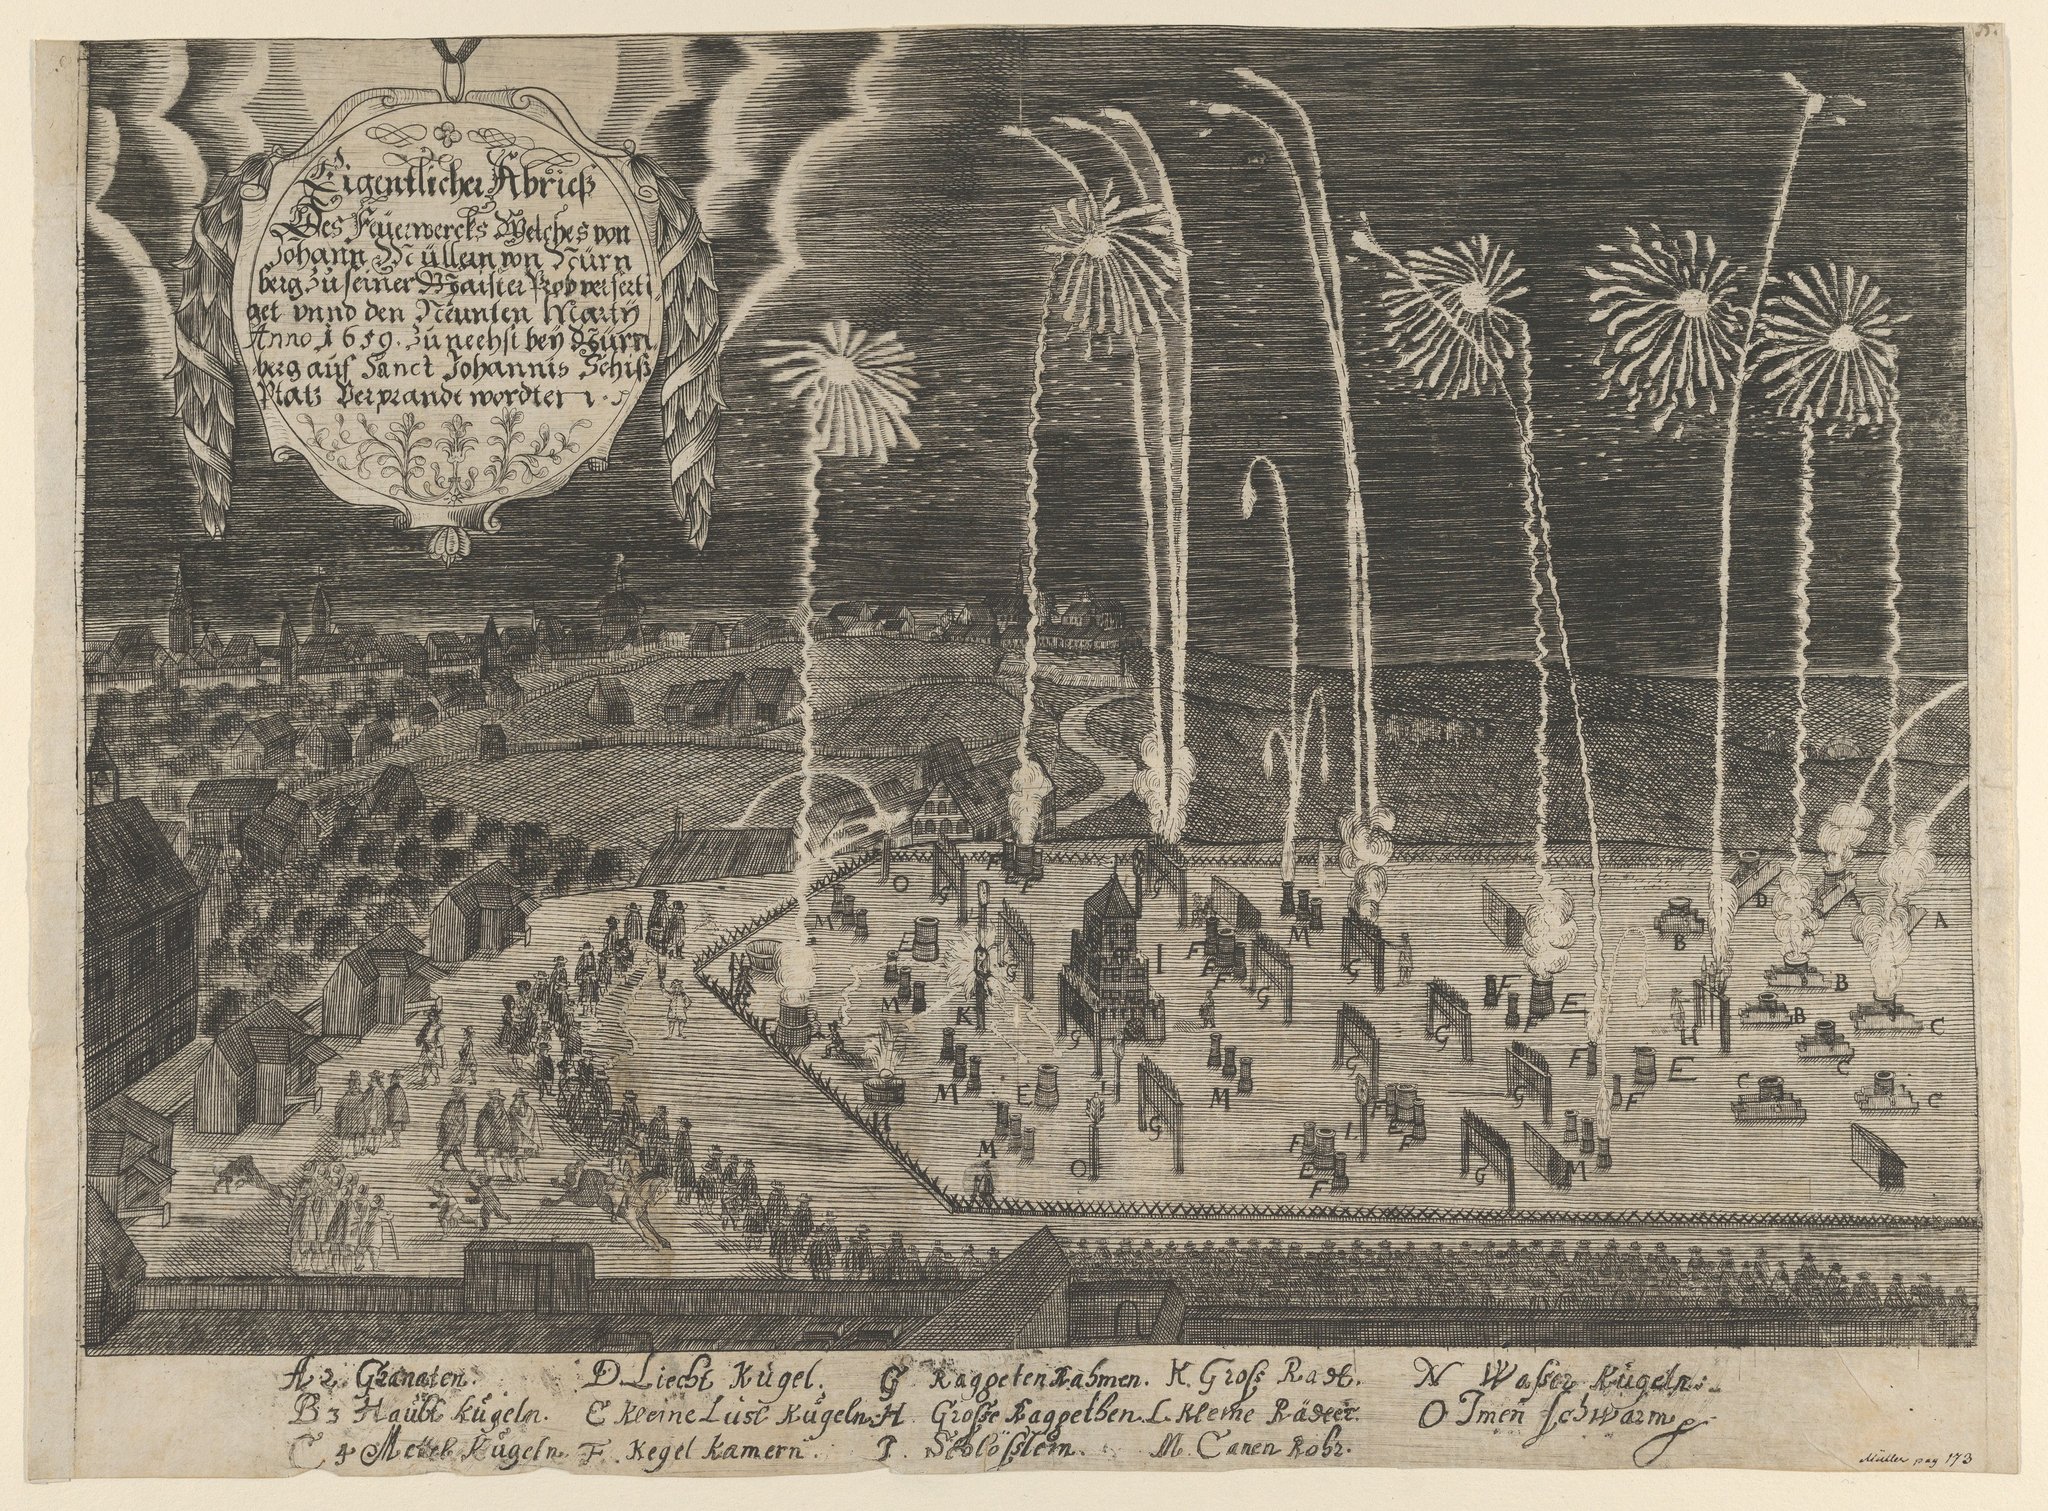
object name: print, fete, ornament architecture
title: A faithful representation of the fireworks display presented by Johann Müller as proof of his Mastership, Johannis Schiessplatz, Nuremberg, 1659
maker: Anonymous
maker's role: artist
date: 1659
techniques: engraving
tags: human figures,fireworks